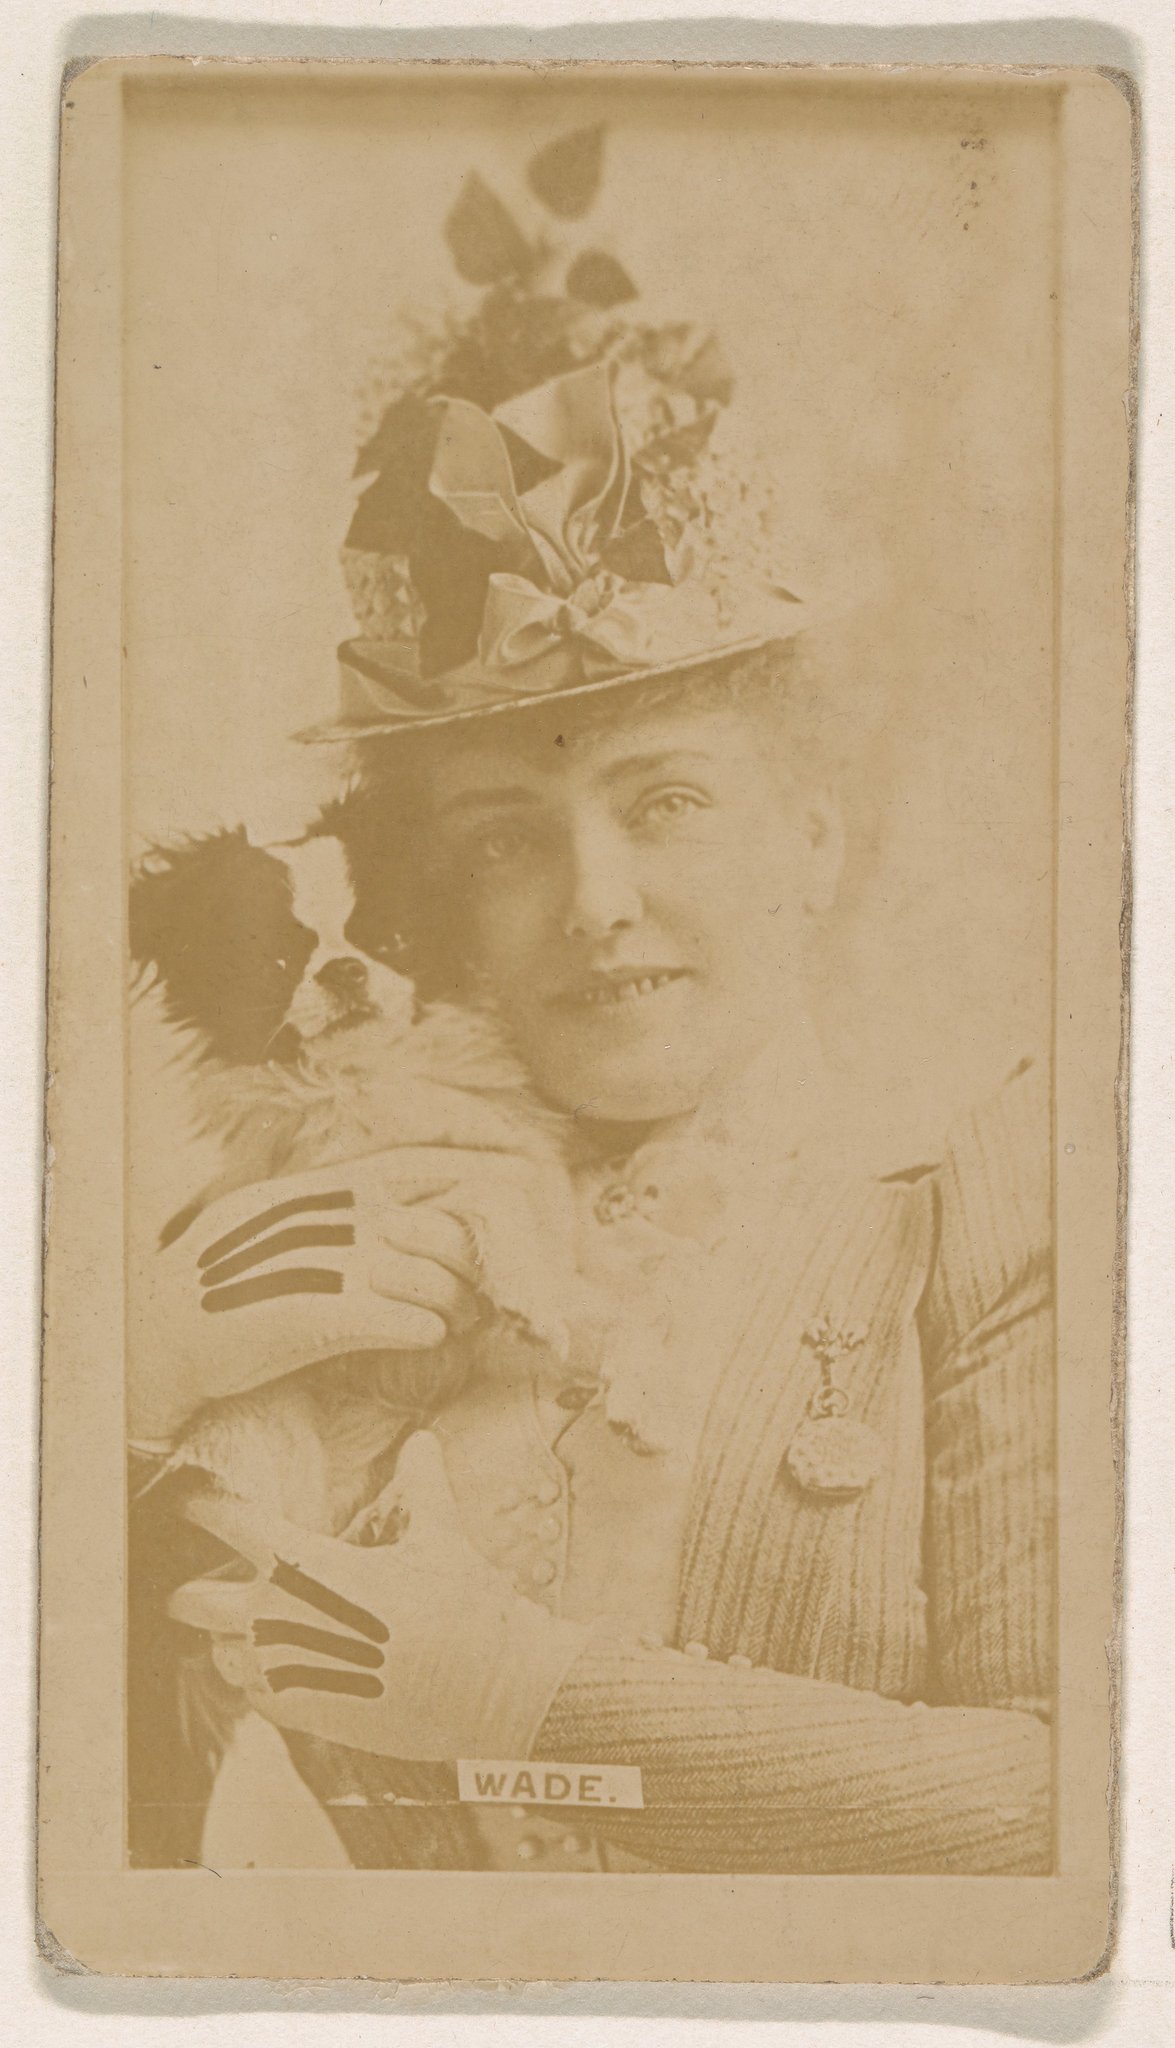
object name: photograph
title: Miss Wade, from the Actresses series (N245) issued by Kinney Brothers to promote Sweet Caporal Cigarettes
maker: kinney brothers tobacco company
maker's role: publisher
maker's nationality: american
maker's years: 1869-2011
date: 1890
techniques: albumen silver print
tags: portraits,women,actresses